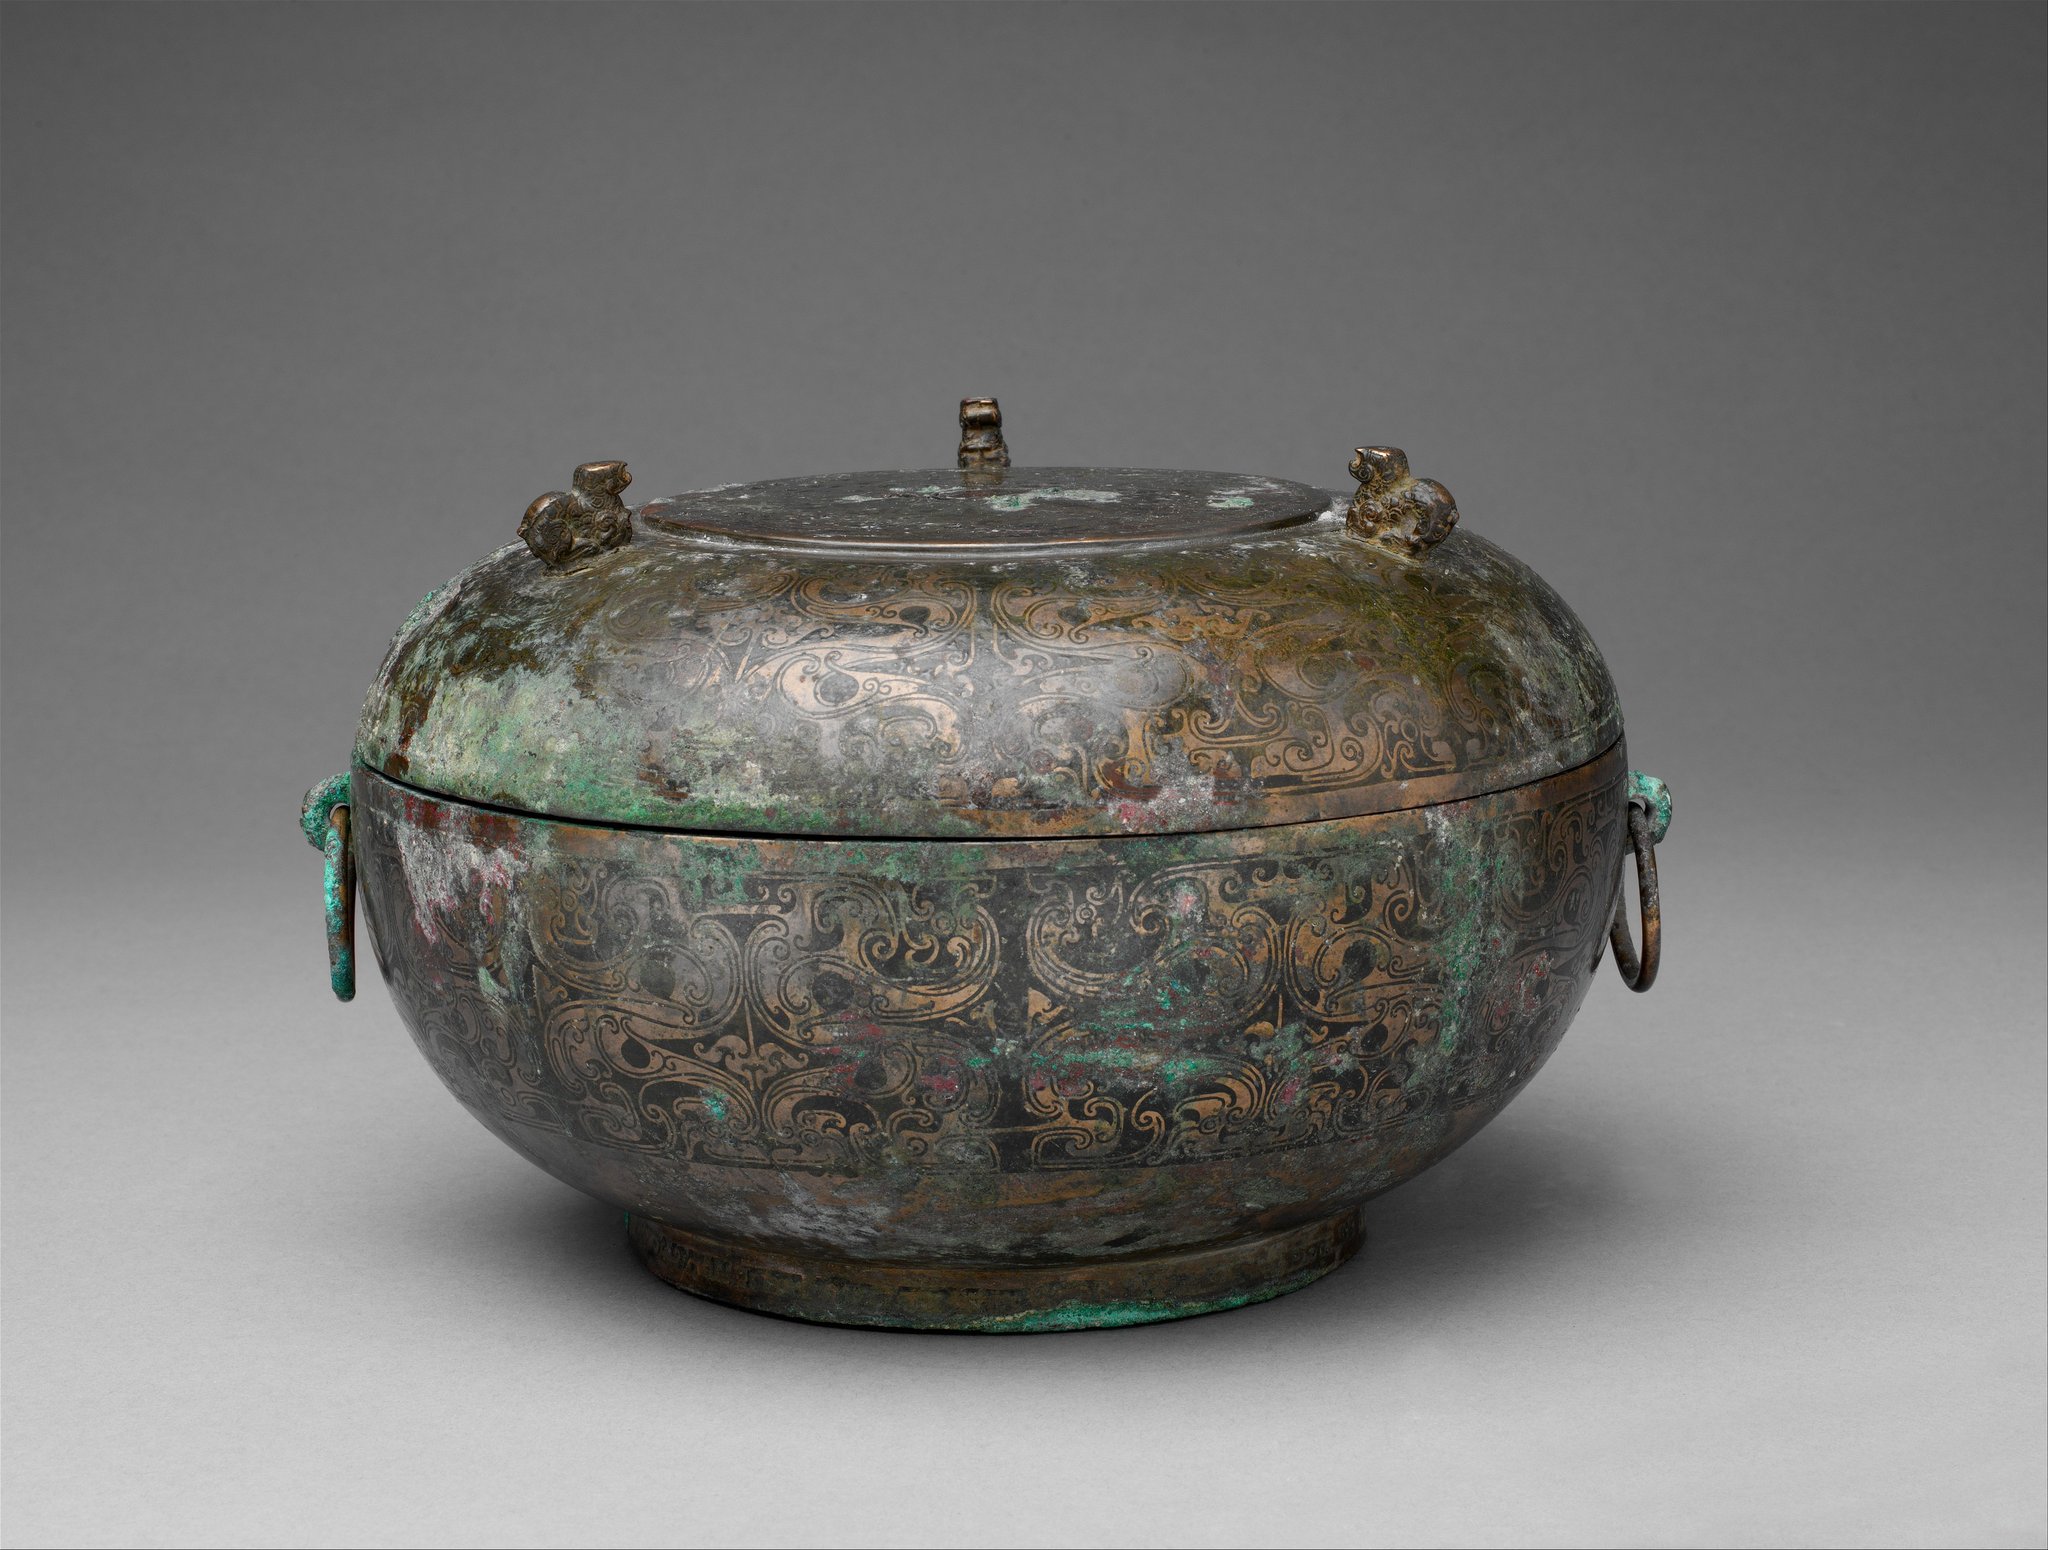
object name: food vessel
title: Food serving vessel (dui)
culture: chinese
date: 400-301 BCE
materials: bone, bronze, lacquer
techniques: inlay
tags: dragons